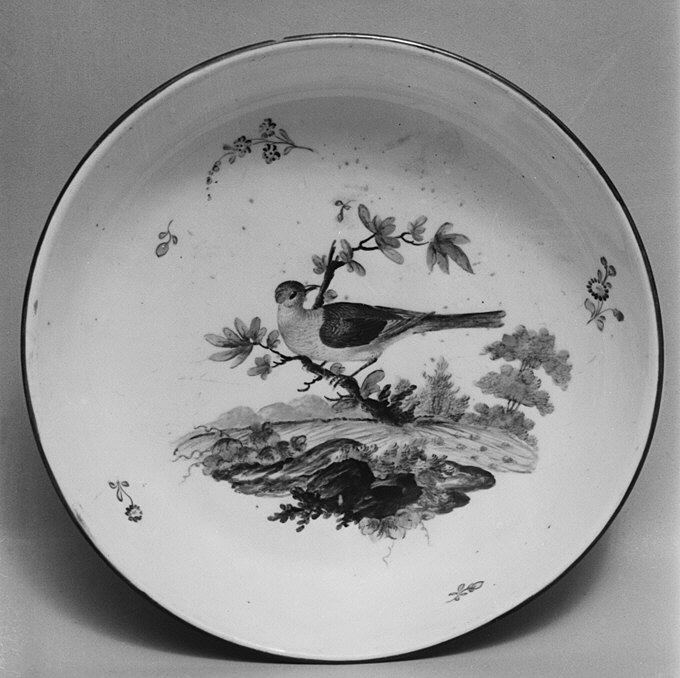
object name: saucer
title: Saucer (part of a service)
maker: frankenthal porcelain manufactory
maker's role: manufactory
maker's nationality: german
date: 1770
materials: hard paste porcelain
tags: birds,plants